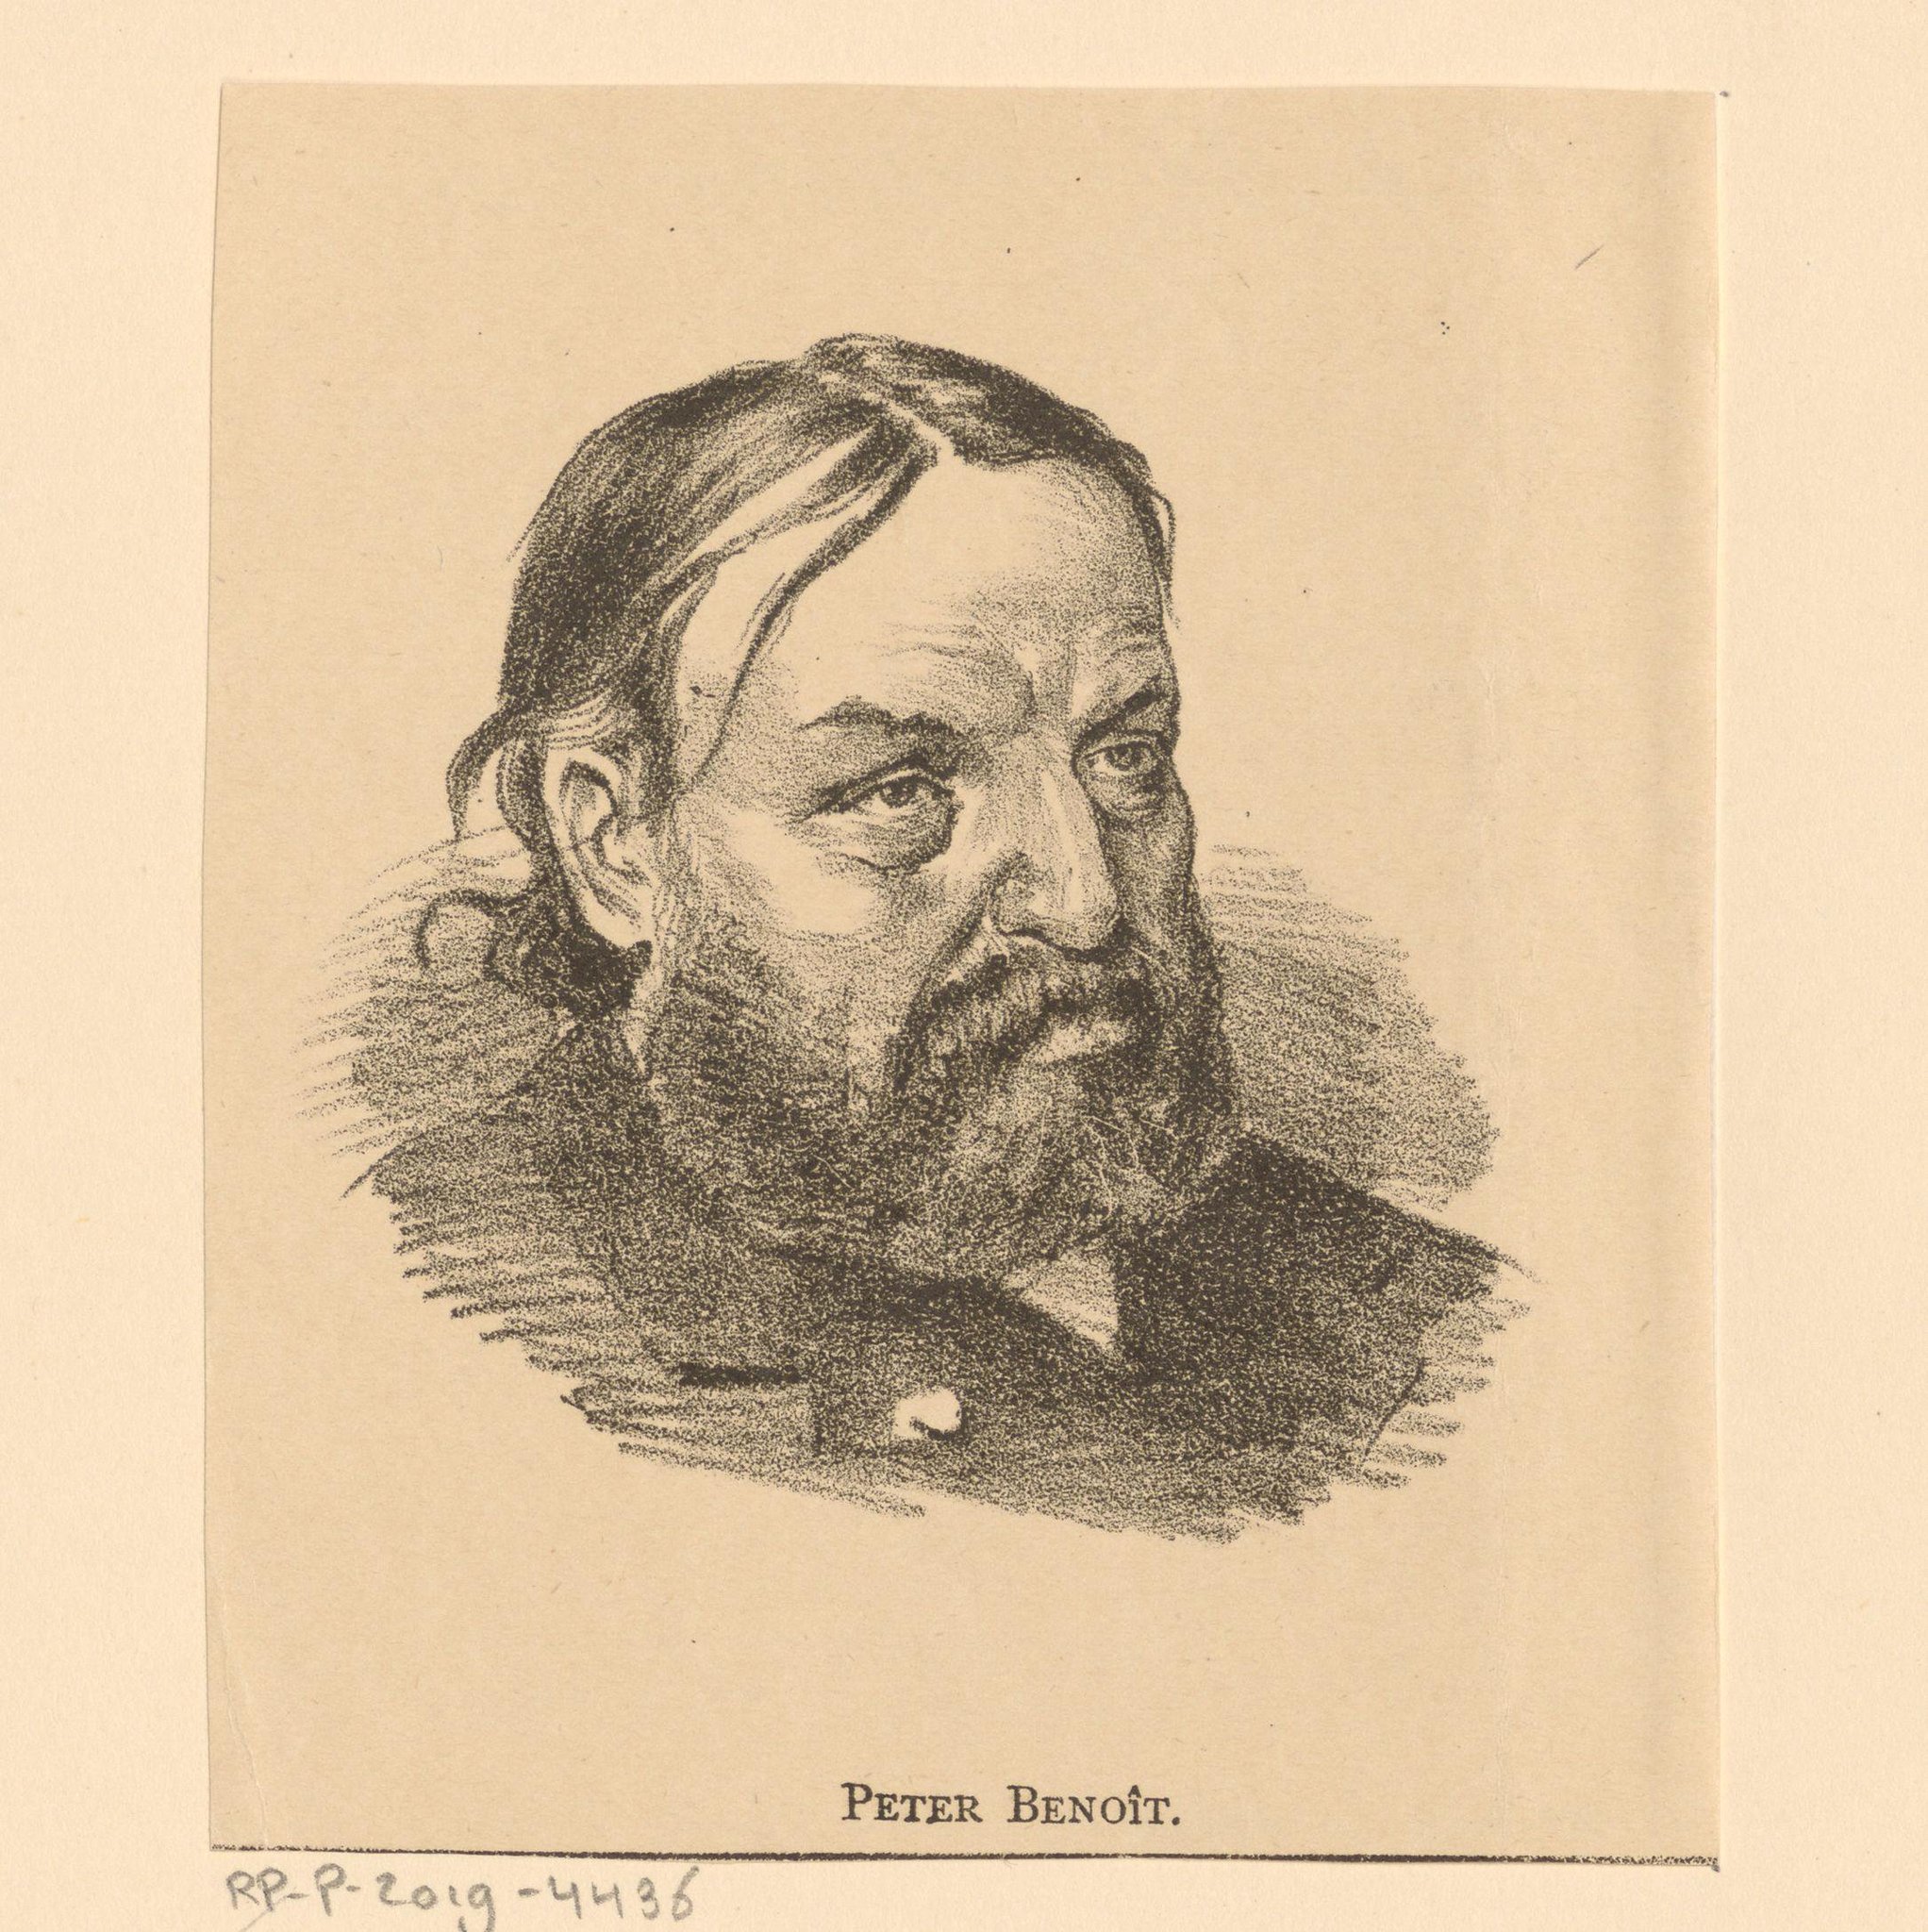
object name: print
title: Portret van Peter Benoit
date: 1866-1928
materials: paper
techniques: lithograph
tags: antwerp, historical persons